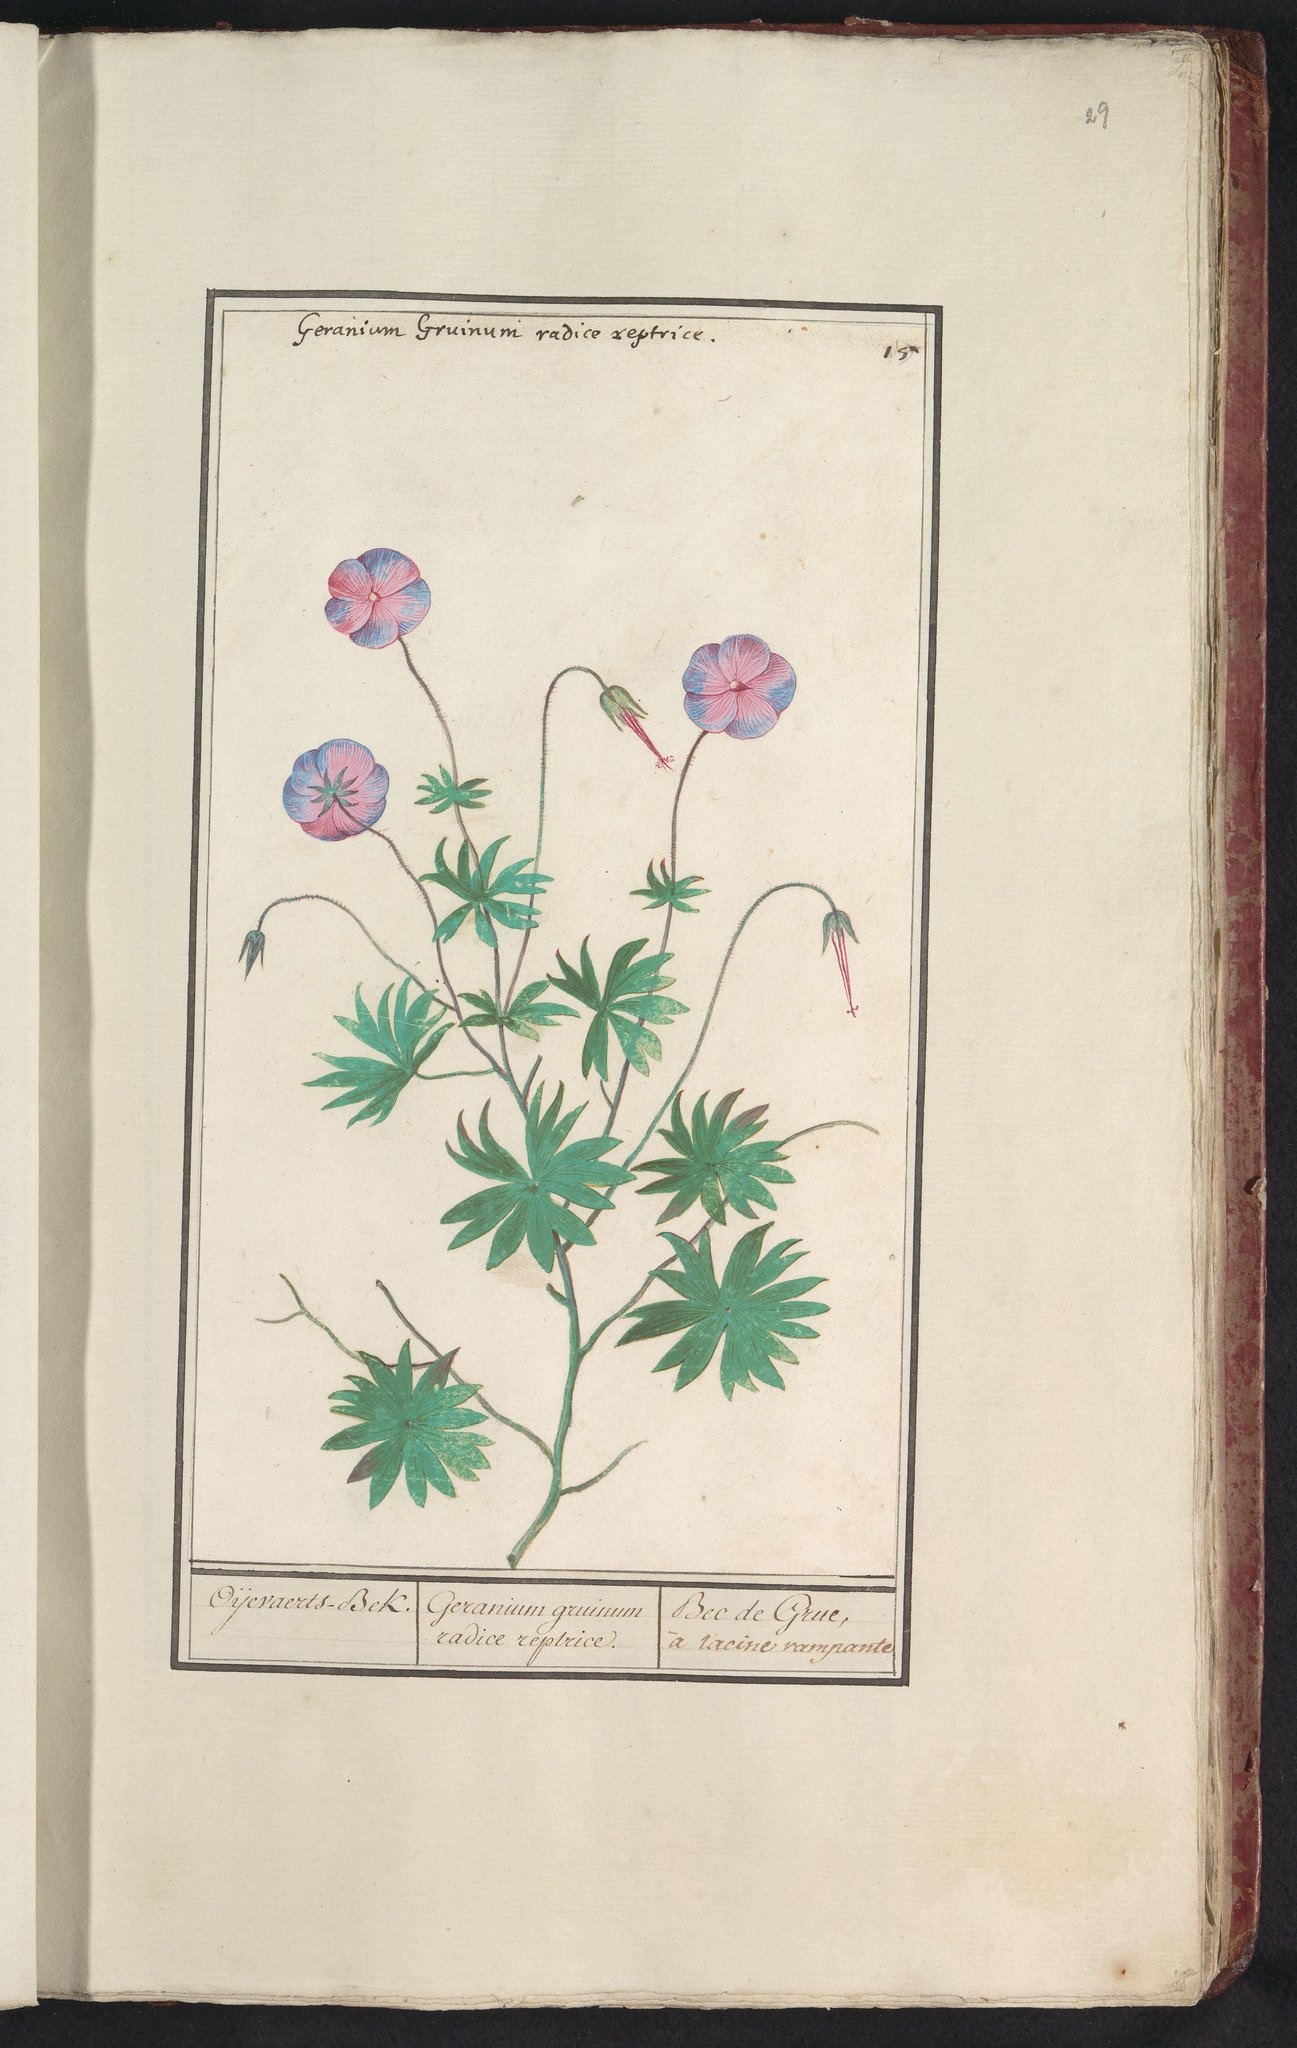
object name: drawing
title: Ooievaarsbek (Geranium)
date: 1596-1610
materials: chalk, paint, ink, paper, watercolor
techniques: brush, pen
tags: flowers: geranium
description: Ooievaarsbek met rozeblauwe bloemen. Genummerd rechtsboven: 15. Bovenaan de Latijnse naam. Onderdeel van het eerste album met tekeningen van bloemen en planten. Achtste van twaalf albums met tekeningen van dieren, vogels en planten bekend rond 1600, gemaakt in opdracht van keizer Rudolf II. Met toelichting in Nederlands, Latijn en Frans.